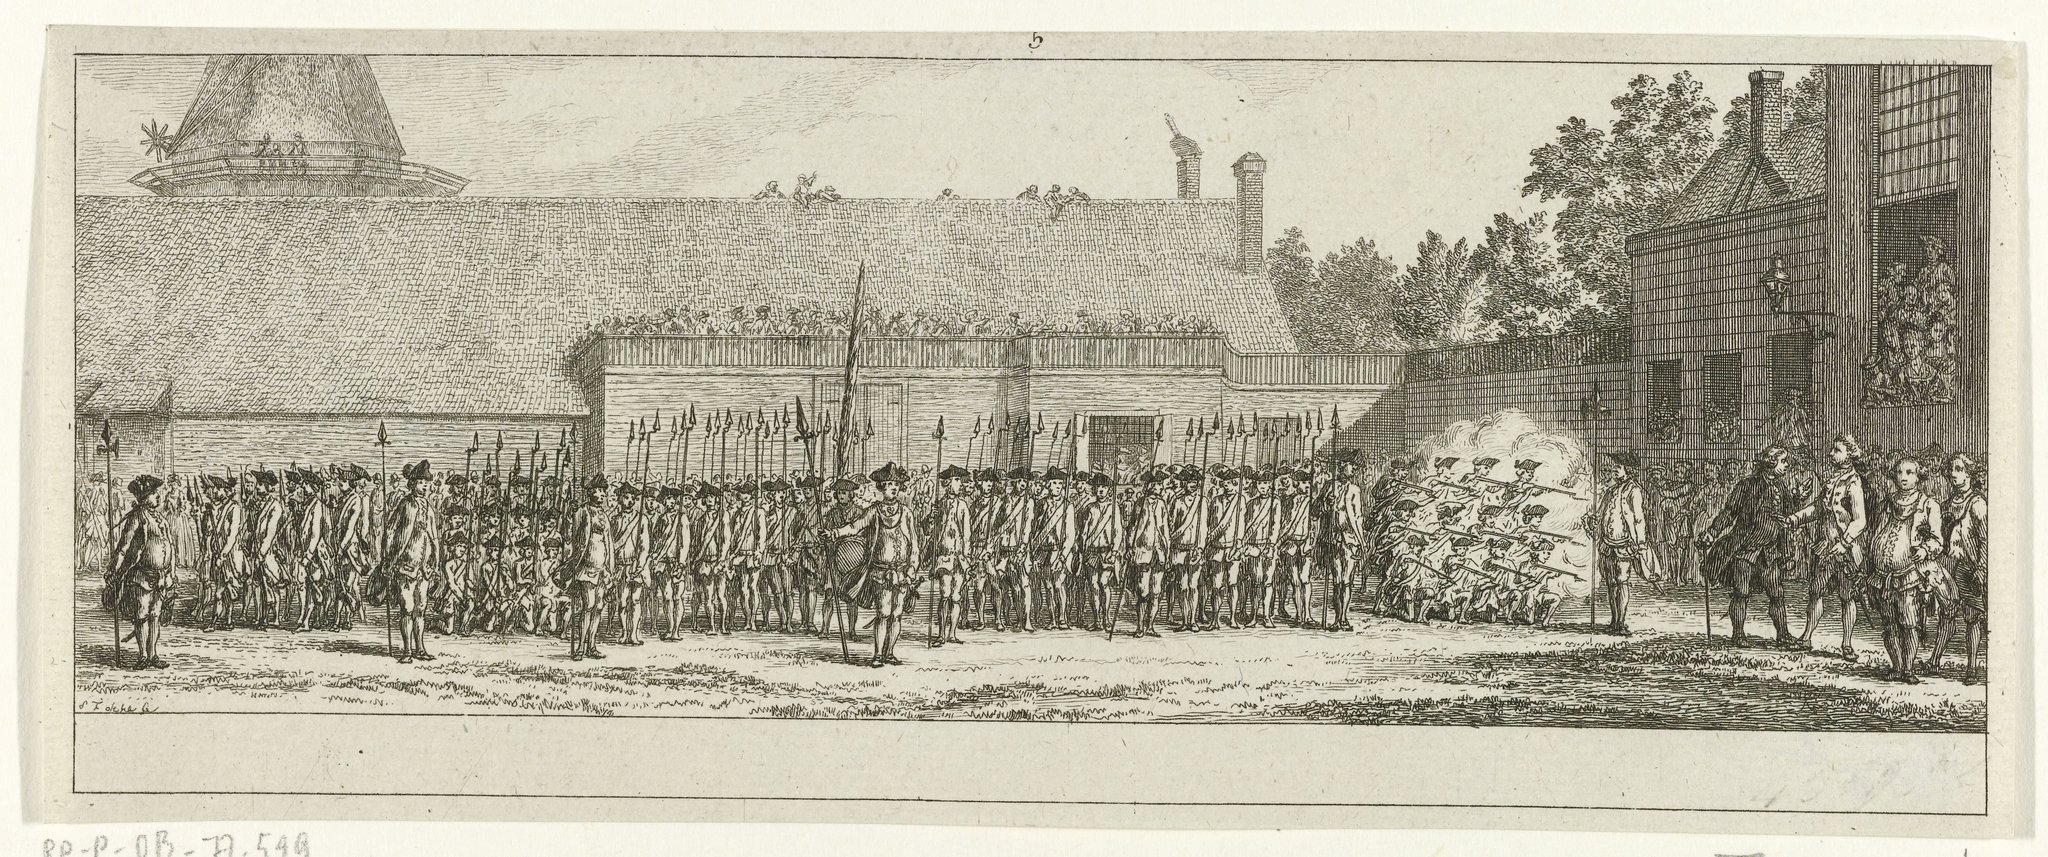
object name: print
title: Exercitie van de Amsterdamse burgerij in tegenwoordigheid van Baron van der Capellen tot den Pol, 1783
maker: simon fokke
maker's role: draughtsman, print maker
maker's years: 1712-1784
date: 1783-1784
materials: paper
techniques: etching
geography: northern netherlands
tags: joan derk van der capellen tot den pol, drill ~ military training (+ citizen soldiery, civil guard, citizen militia)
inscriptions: collector's mark: Lugt 2228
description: Exercitie en schietoefeningen van de Amsterdamse burgerij op het Drilveld, onder commando van kapitein Huybert Bastert, in aanwezigheid van Joan Derk van der Capellen tot den Pol, 26 april 1783.